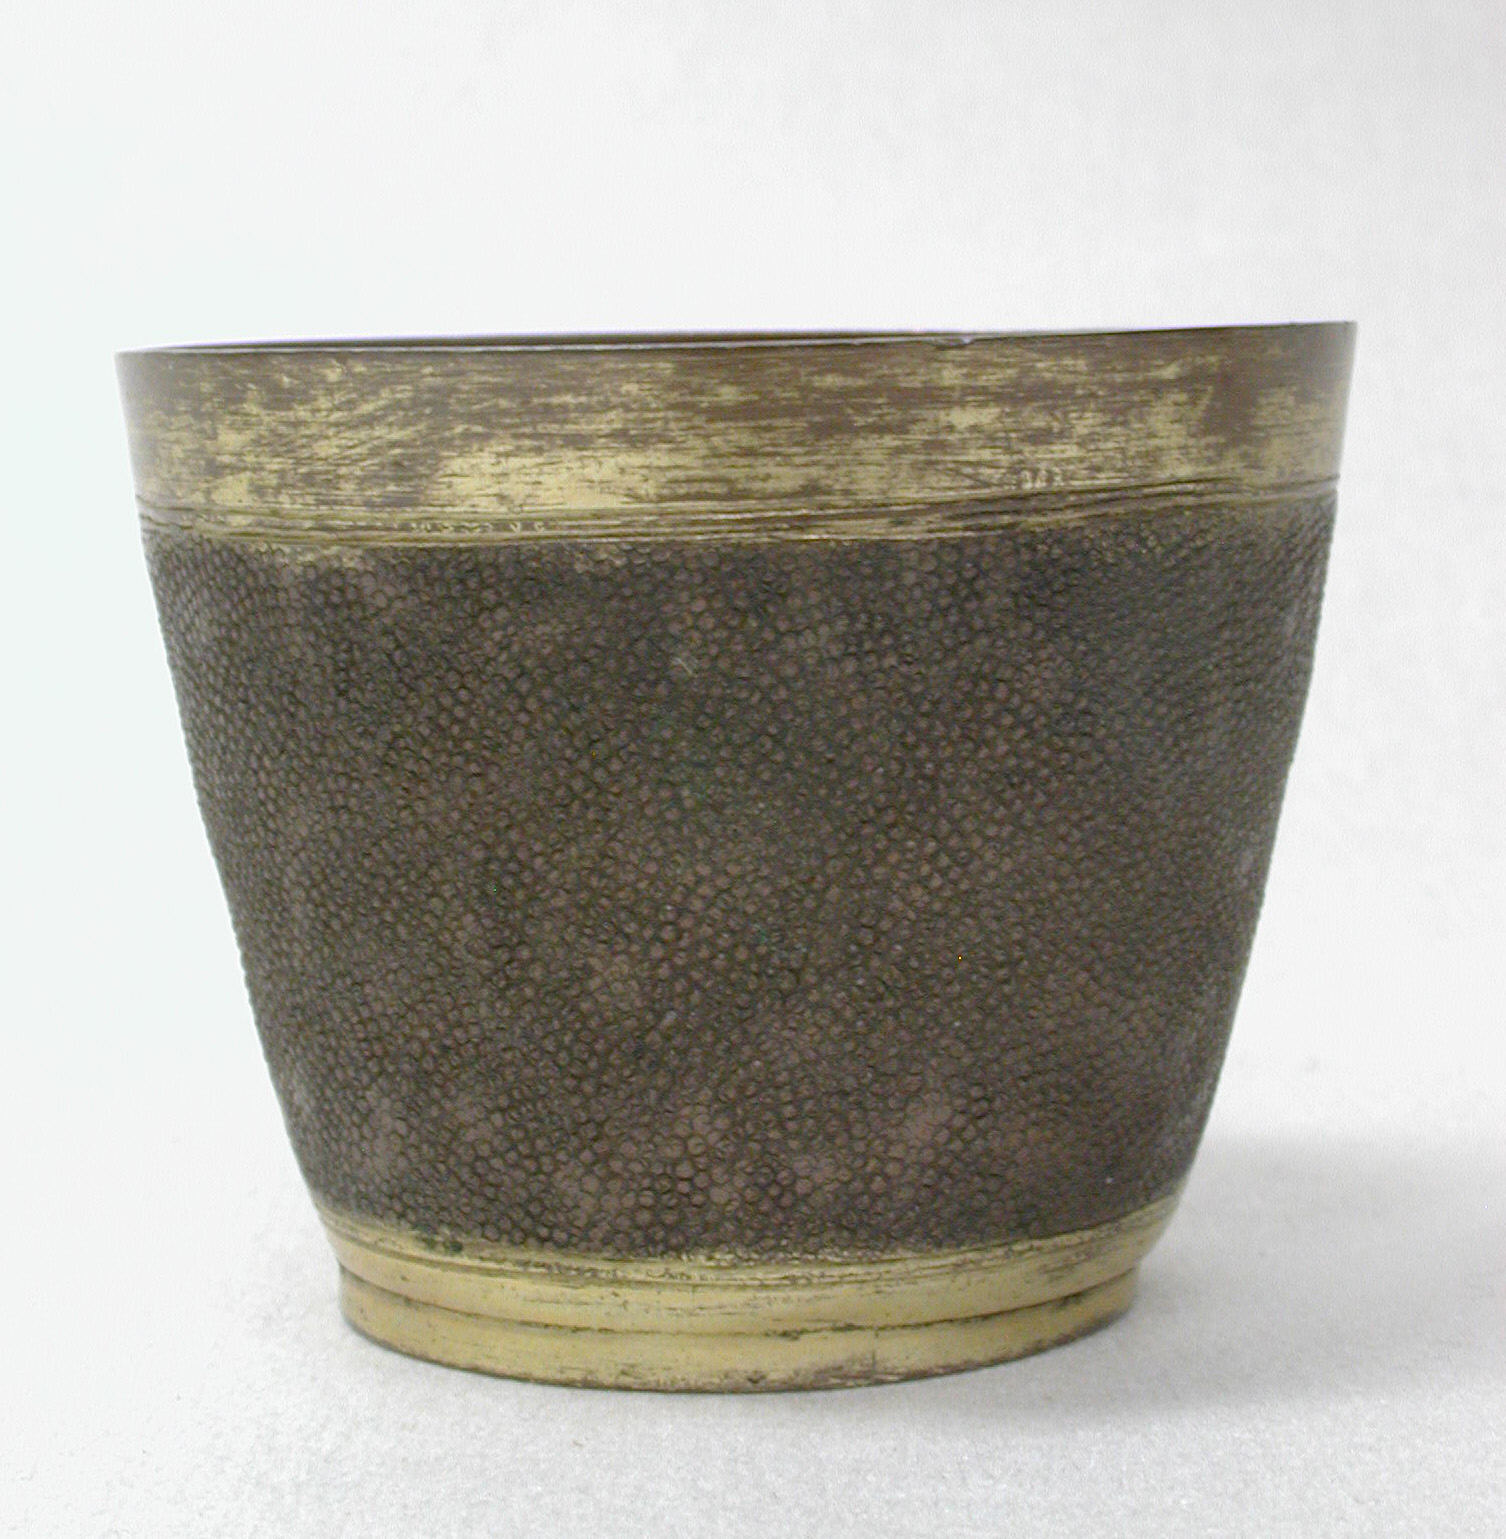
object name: cup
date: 1667-1733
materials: copper gilt